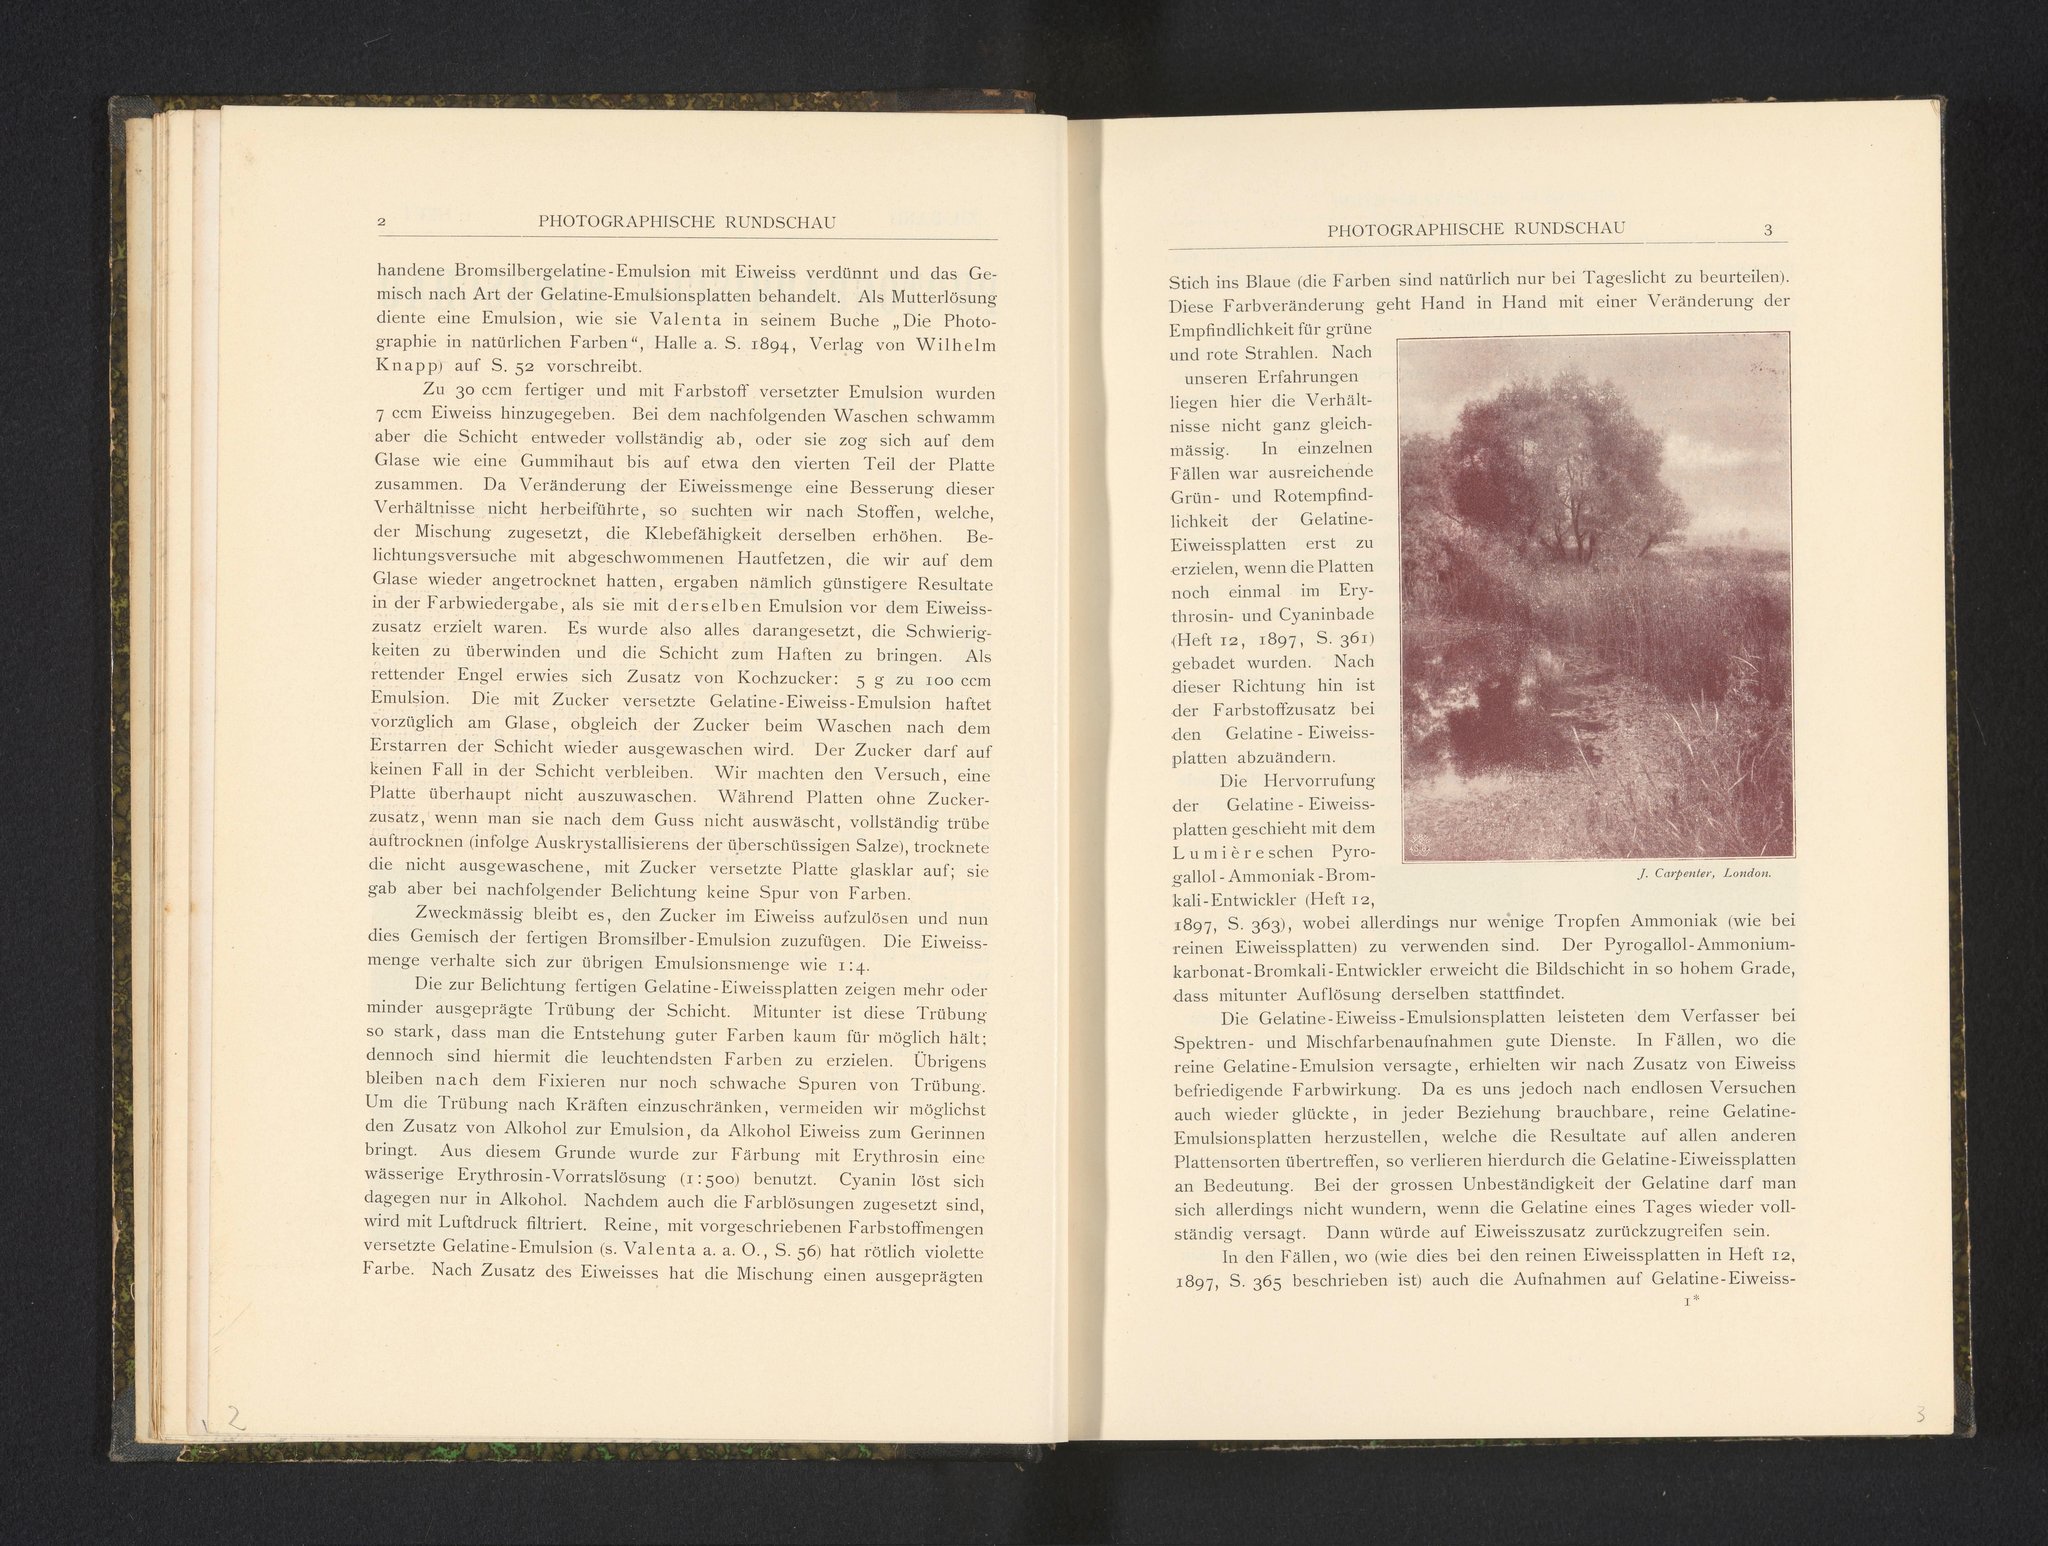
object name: photomechanical print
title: Gezicht op een sloot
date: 1893-1898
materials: paper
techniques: autotype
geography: london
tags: brook